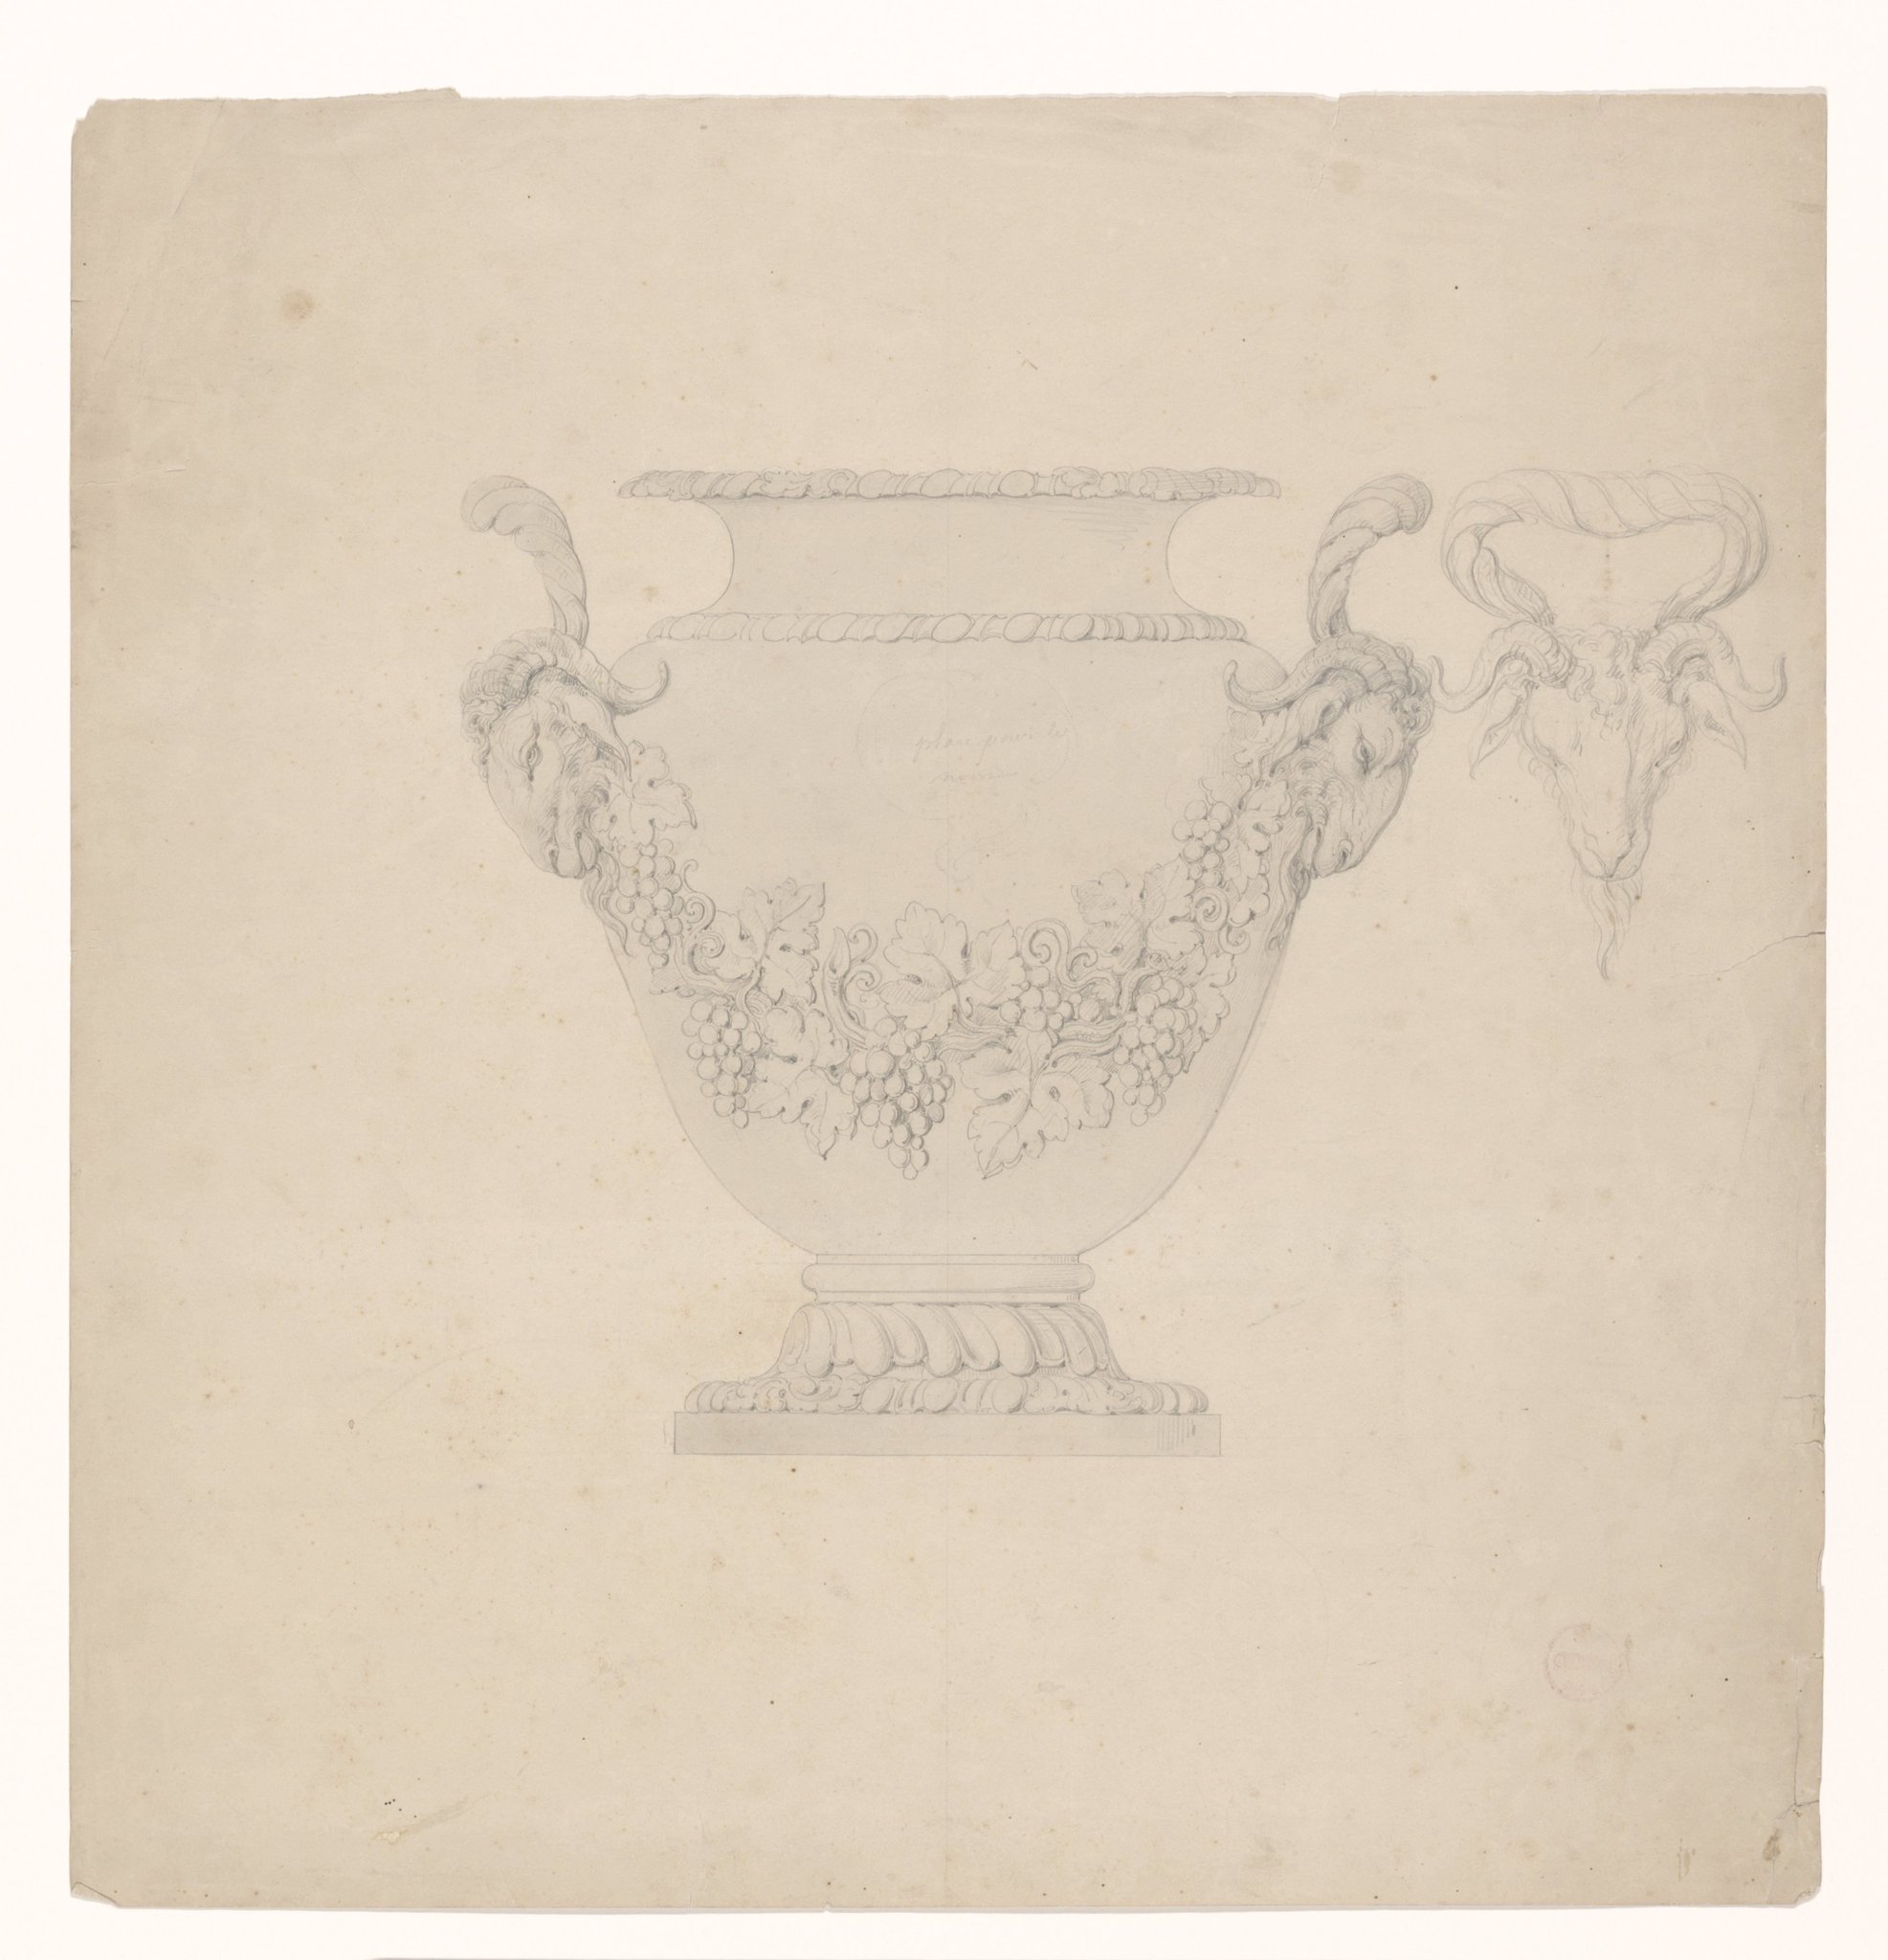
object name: design drawing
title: Ontwerp voor wijnkoeler (op ware grootte)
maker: charles nicolas odiot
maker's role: jeweler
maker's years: 1789-1869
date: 1830-1835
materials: paper, pencil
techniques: brush, drawing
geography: paris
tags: dinner-service, wine-cooler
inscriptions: stamp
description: Rechts van het ontwerp een vooraanzicht van een oor, in de vorm van een ramskop. In een geschechetste rococo-cartouche op het lichaam van de wijnkoeler: place pour le / nom.